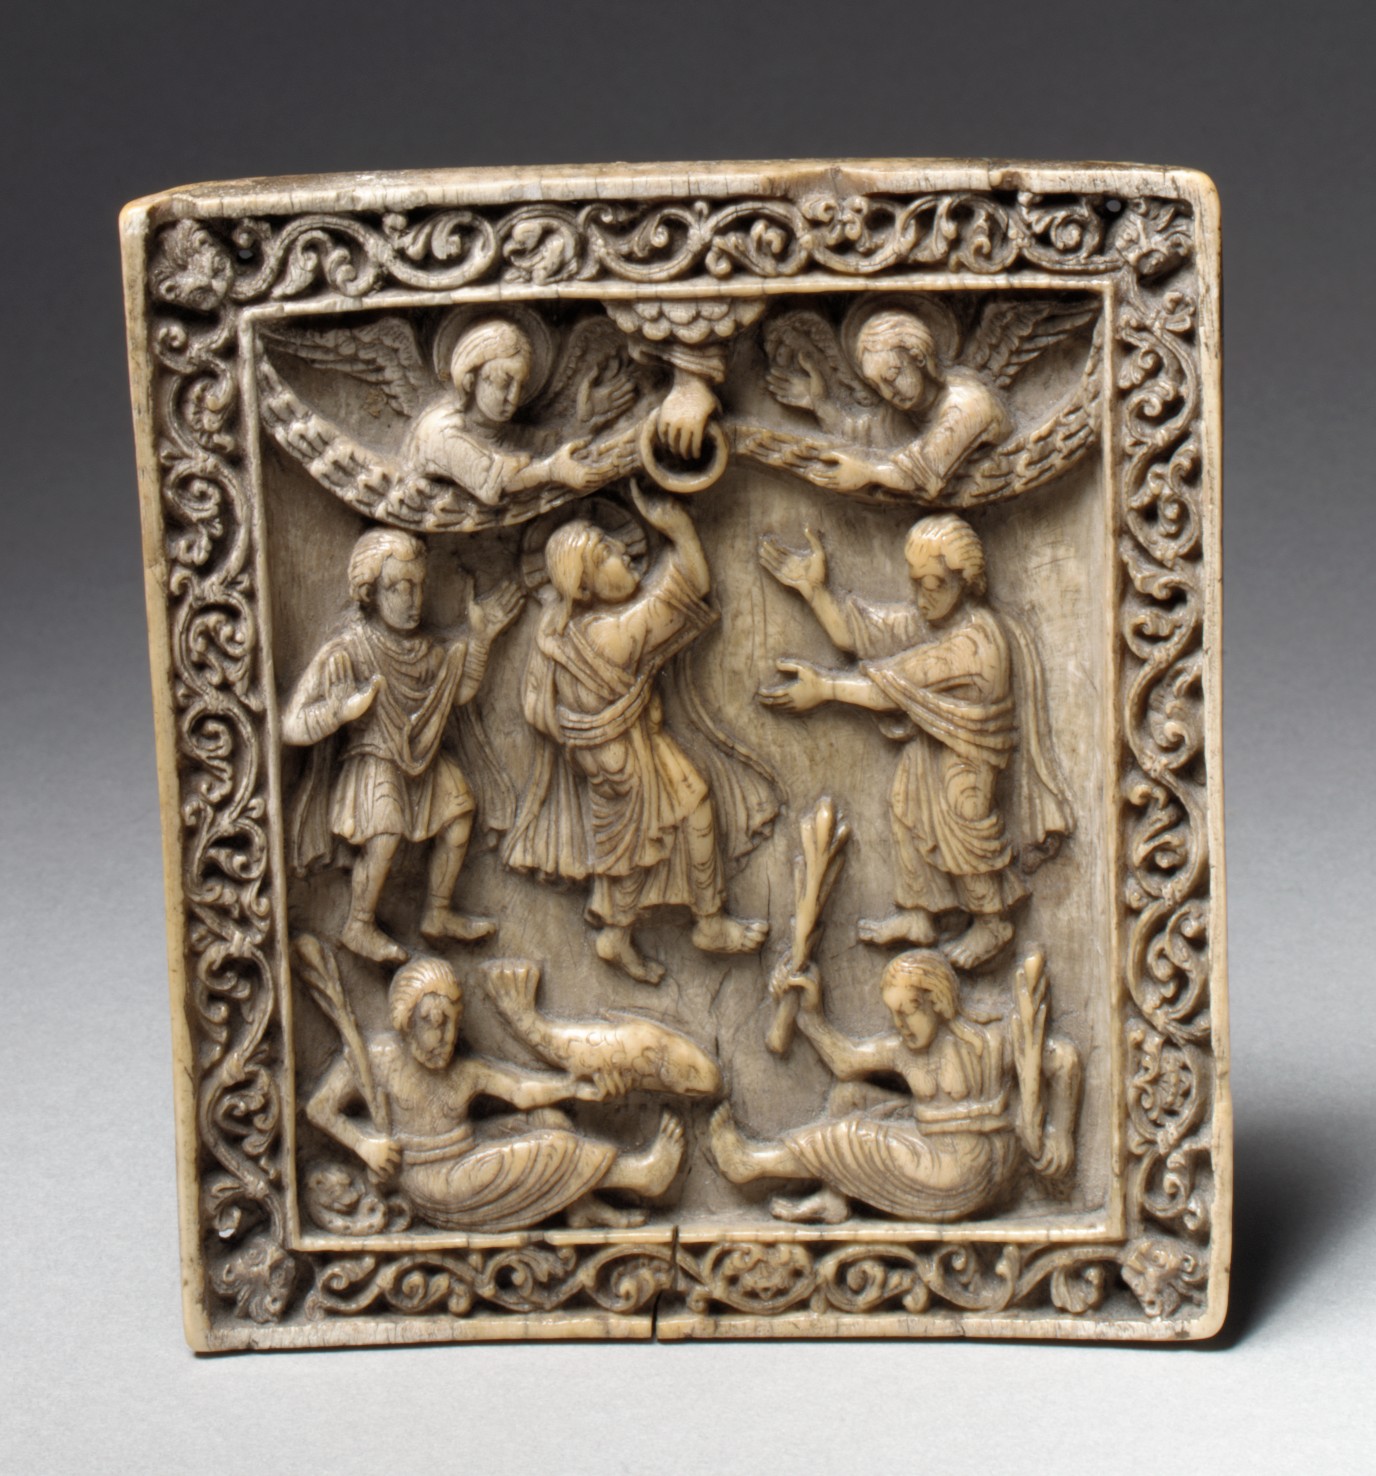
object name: plaque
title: Plaque with the Ascension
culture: german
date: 1050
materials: ivory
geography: germany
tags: christ